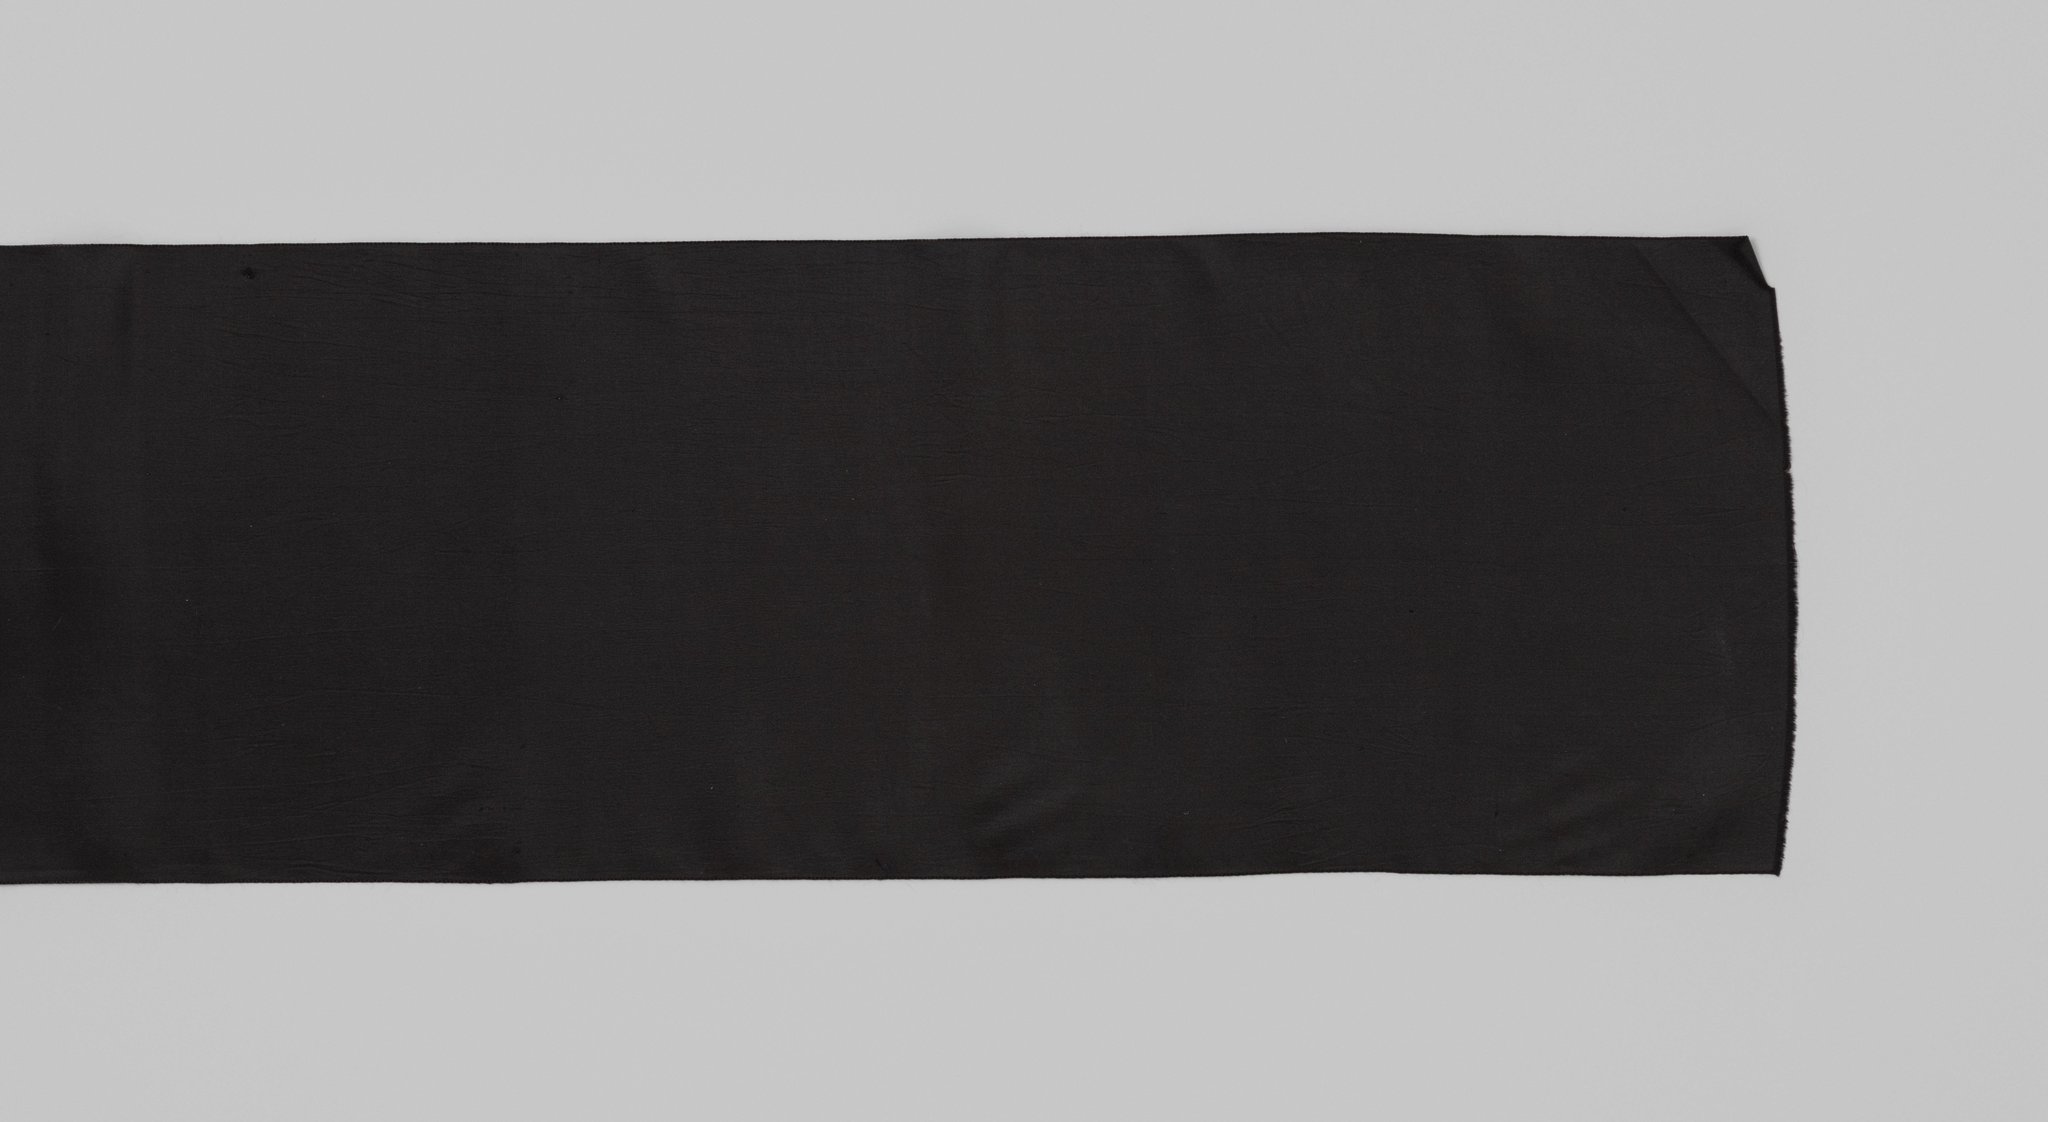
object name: clothing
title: Lint van zwarte zijde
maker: Anonymous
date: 1400-1950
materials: silk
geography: western europe